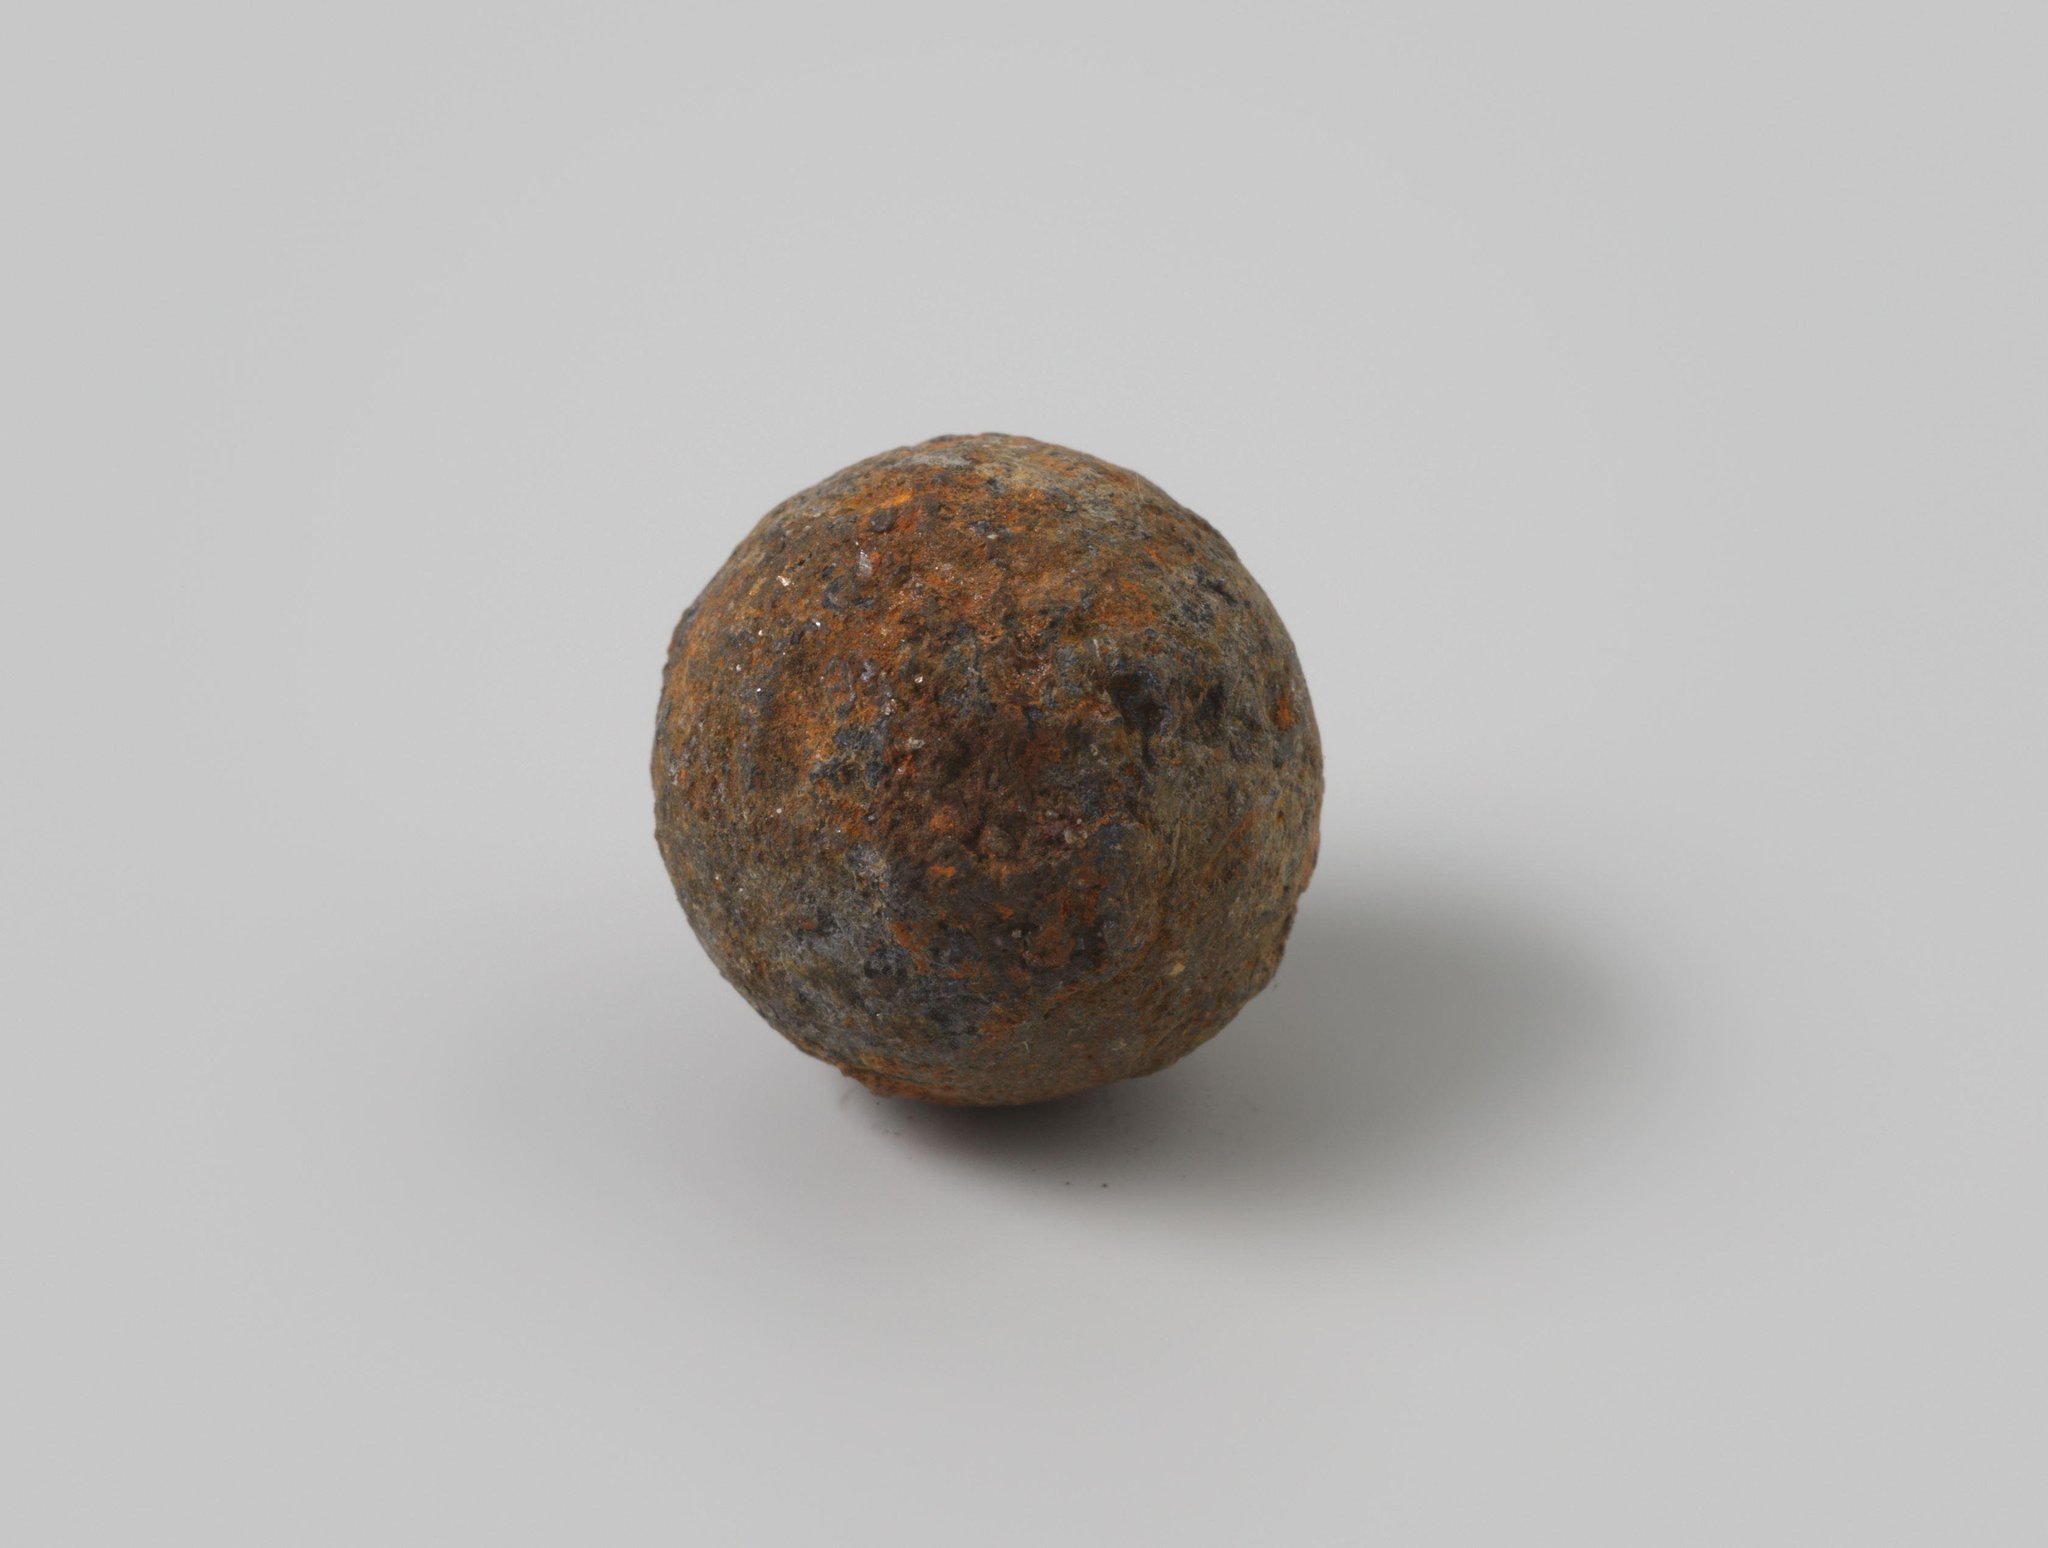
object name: musketkogel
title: Musketkogel uit het wrak van de Oost-Indiëvaarder Hollandia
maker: Anonymous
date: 1700-1743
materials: lead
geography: netherlands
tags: verenigde oostindische compagnie, hollandia (schip), annet